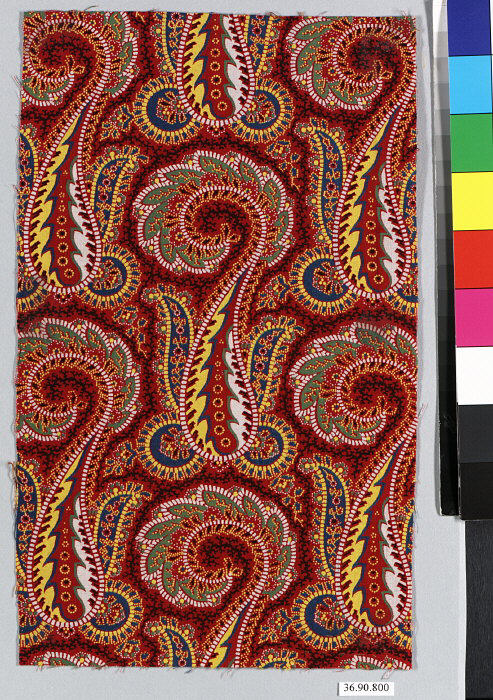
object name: piece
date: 1867-1900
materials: cotton